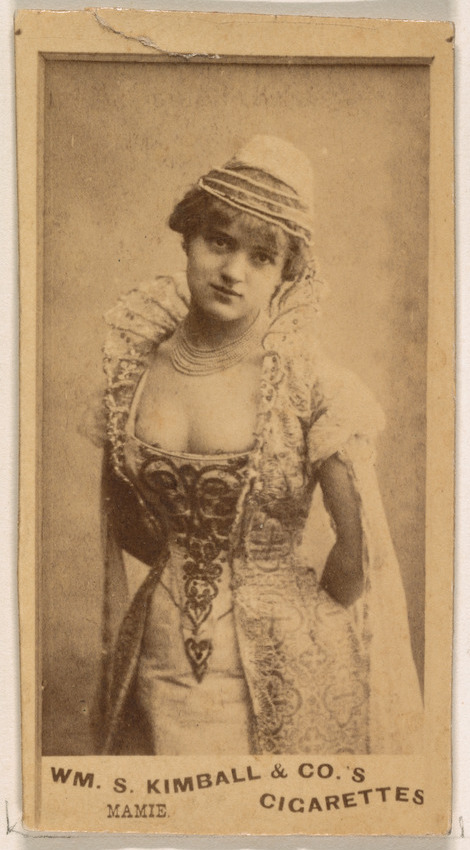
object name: photograph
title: Miss Mamie, from the Actresses series (N203) issued by Wm. S. Kimball & Co.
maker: william s. kimball & company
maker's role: publisher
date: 1889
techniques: color lithograph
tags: portraits,women,actresses